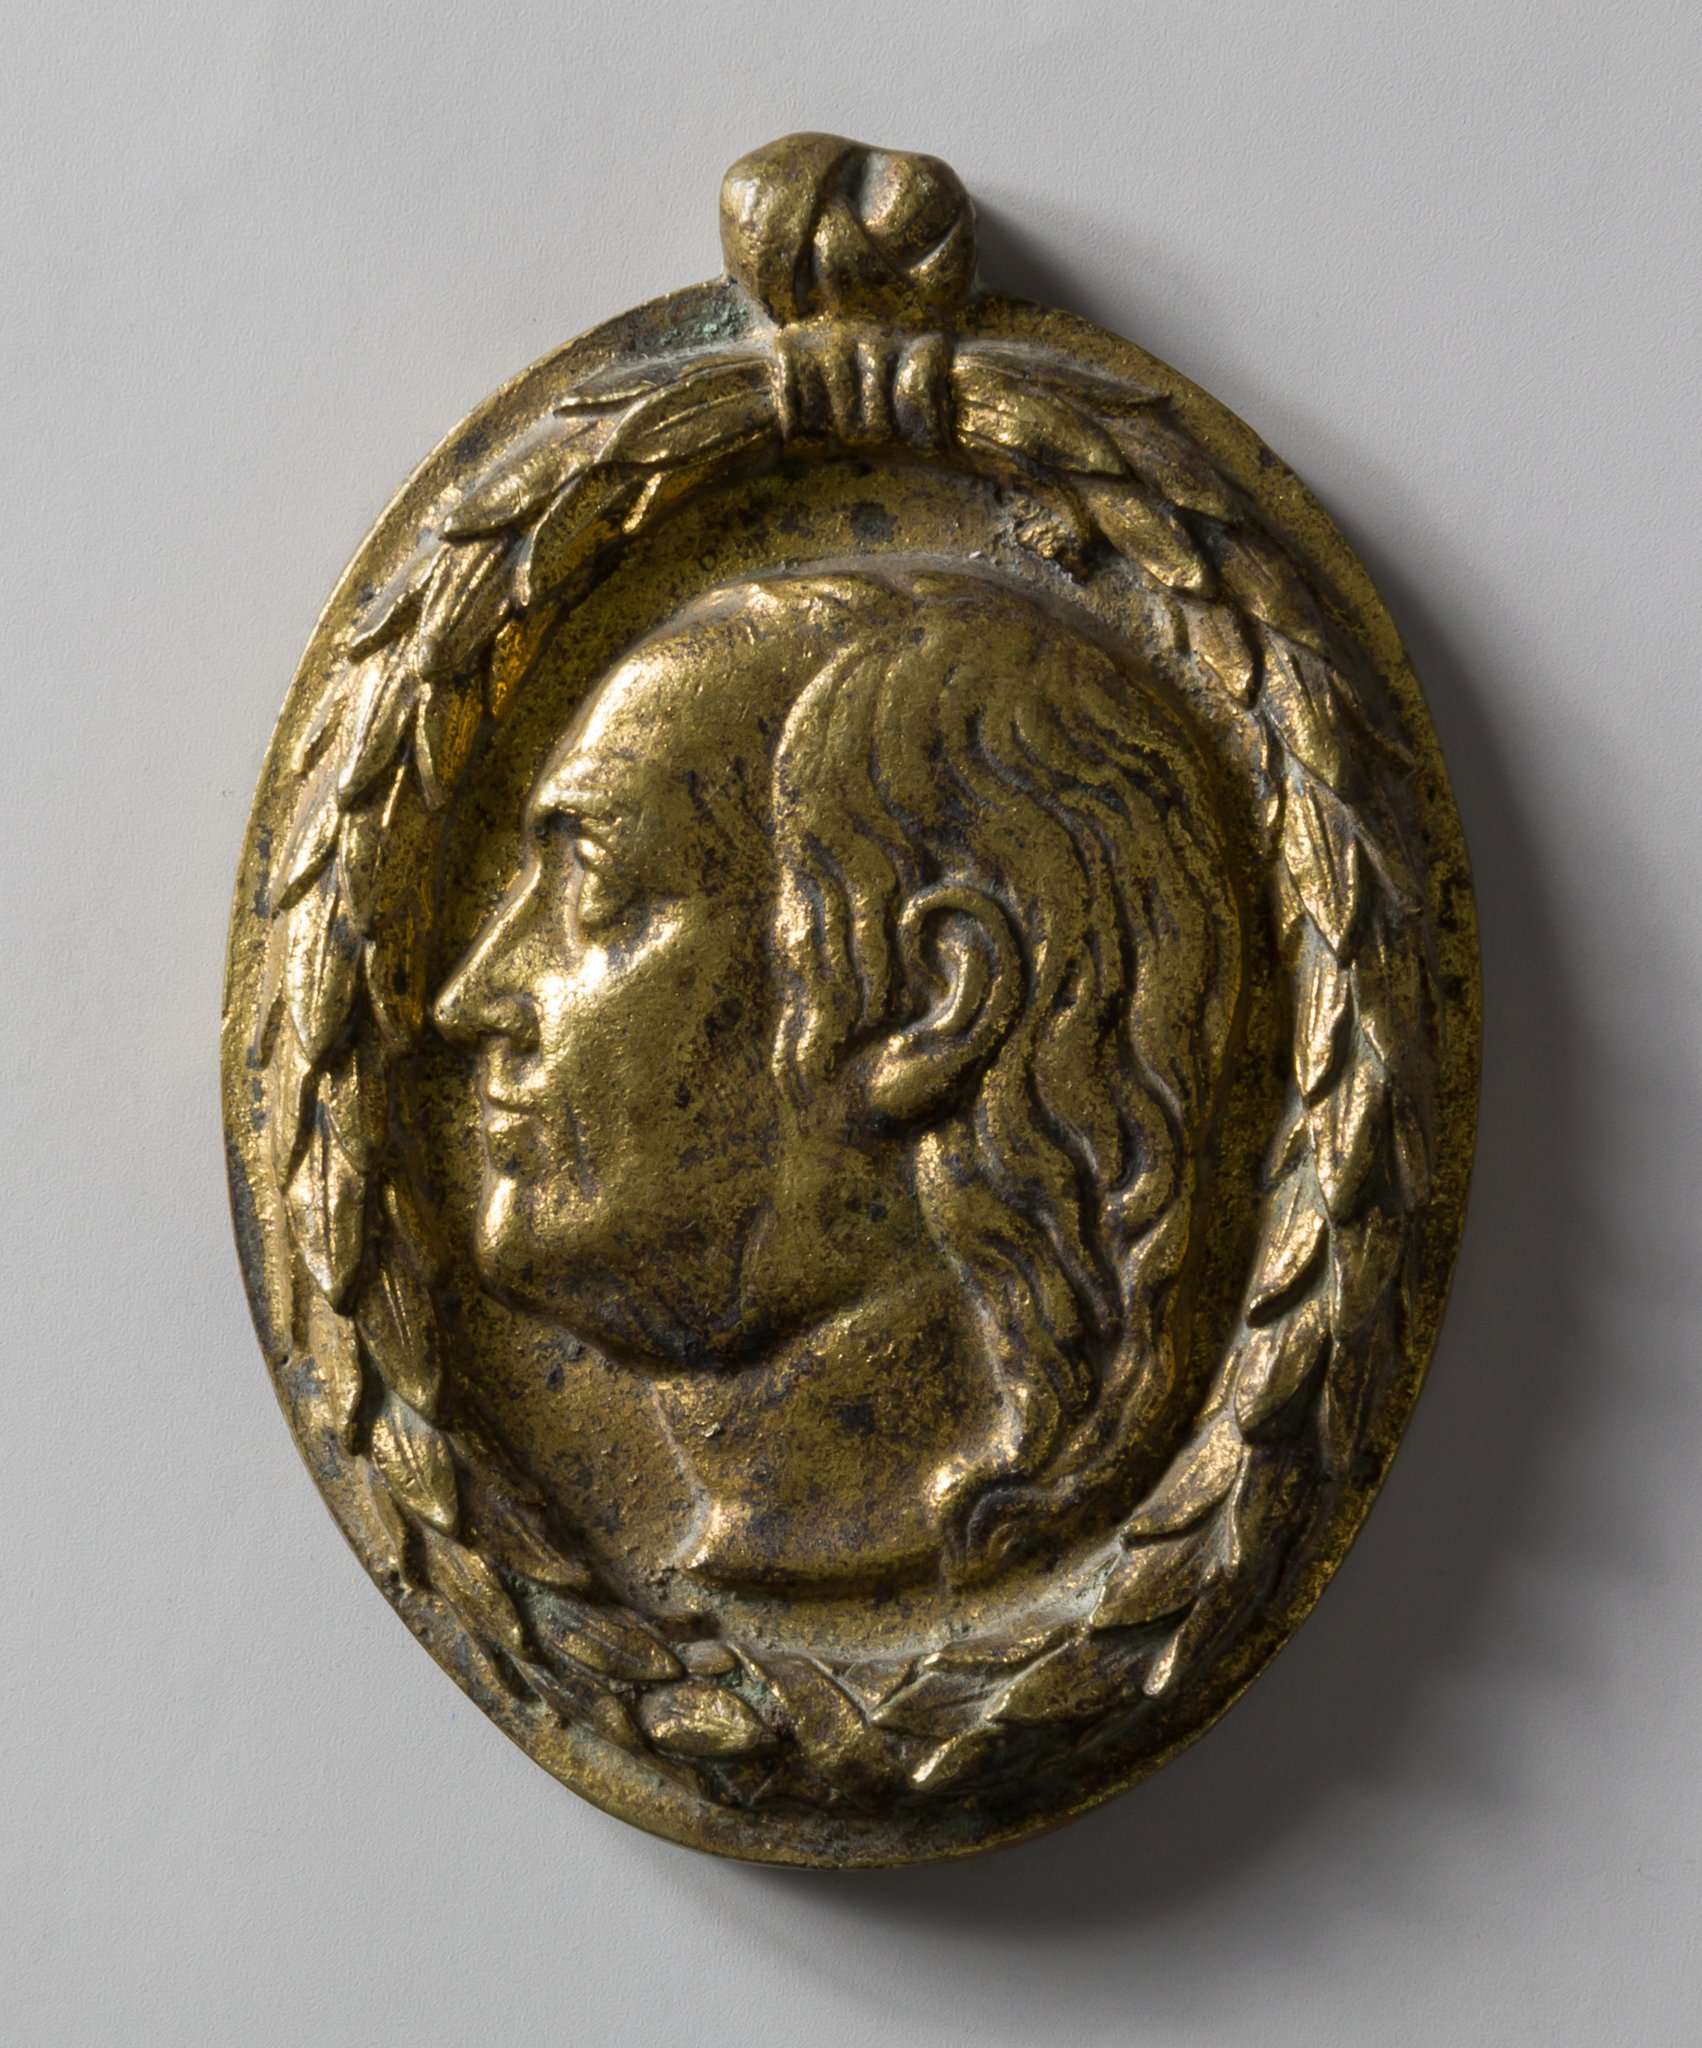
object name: medallion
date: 1870-1900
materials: brass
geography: france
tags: men,profiles